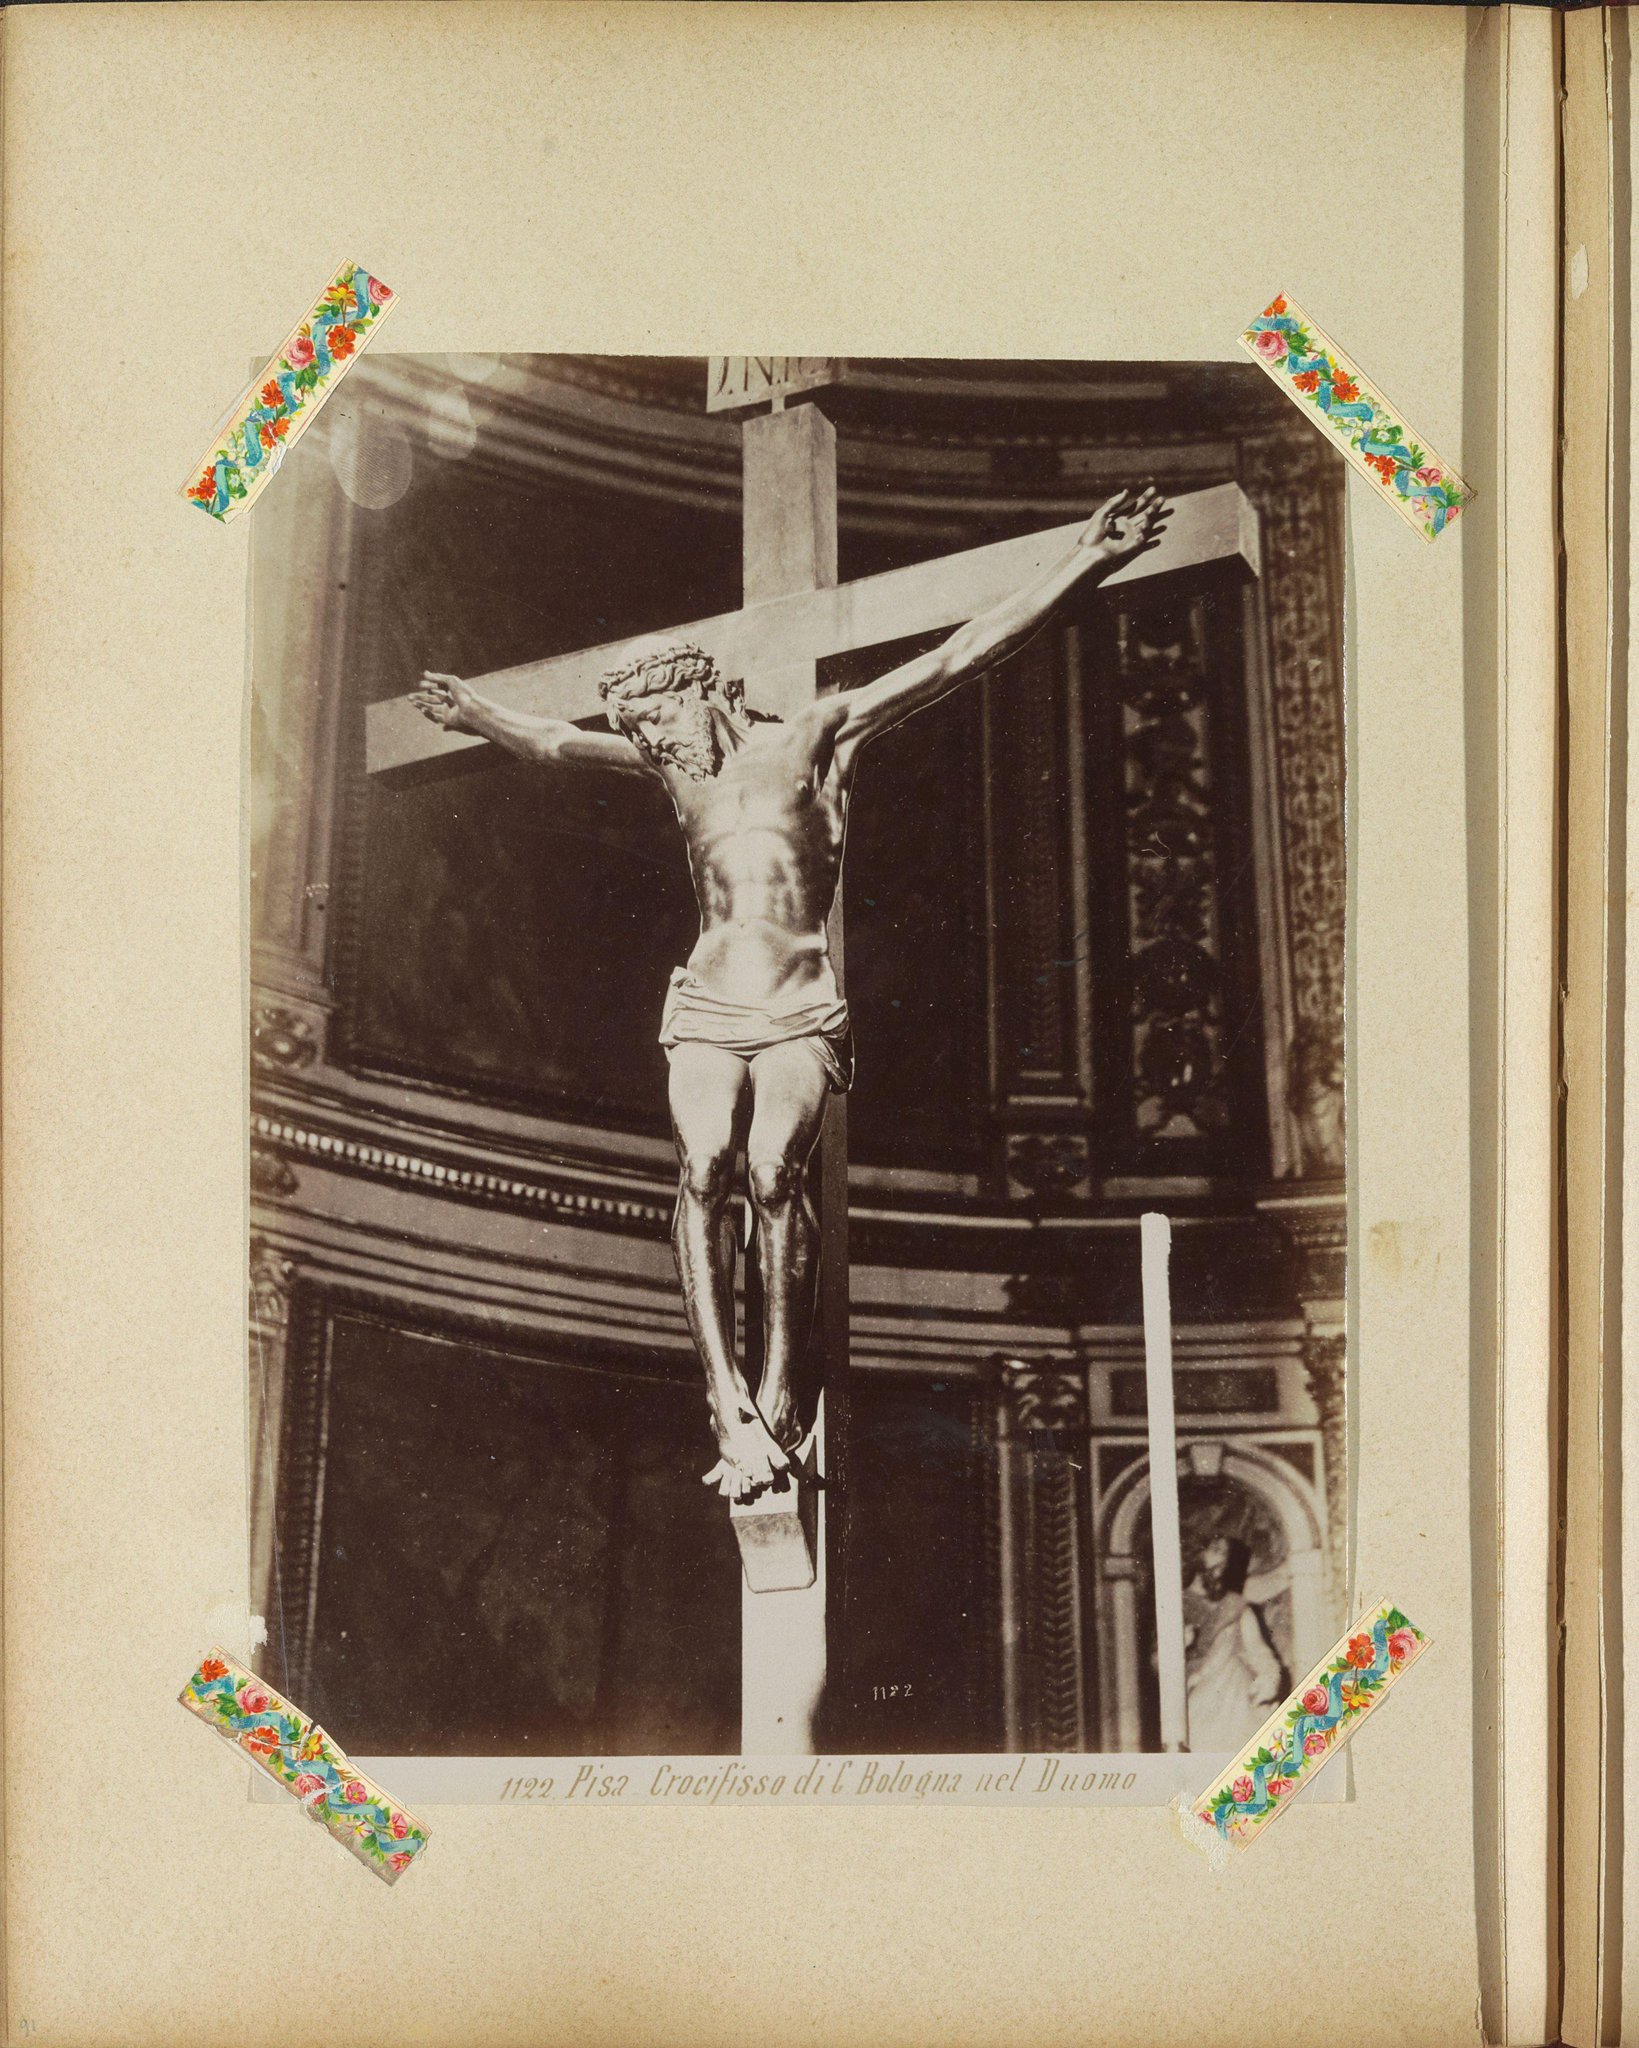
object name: photograph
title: Pisa. Crocifisso di C. Bologna nel Duomo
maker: Anonymous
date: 1860-1900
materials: photographic support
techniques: albumen print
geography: pisa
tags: crucifix ~ personal devotion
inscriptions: number: ‘1122’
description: Onderdeel van Fotoalbum met opnames van bezienswaardigheden in Italiaanse steden en van kunstwerken.